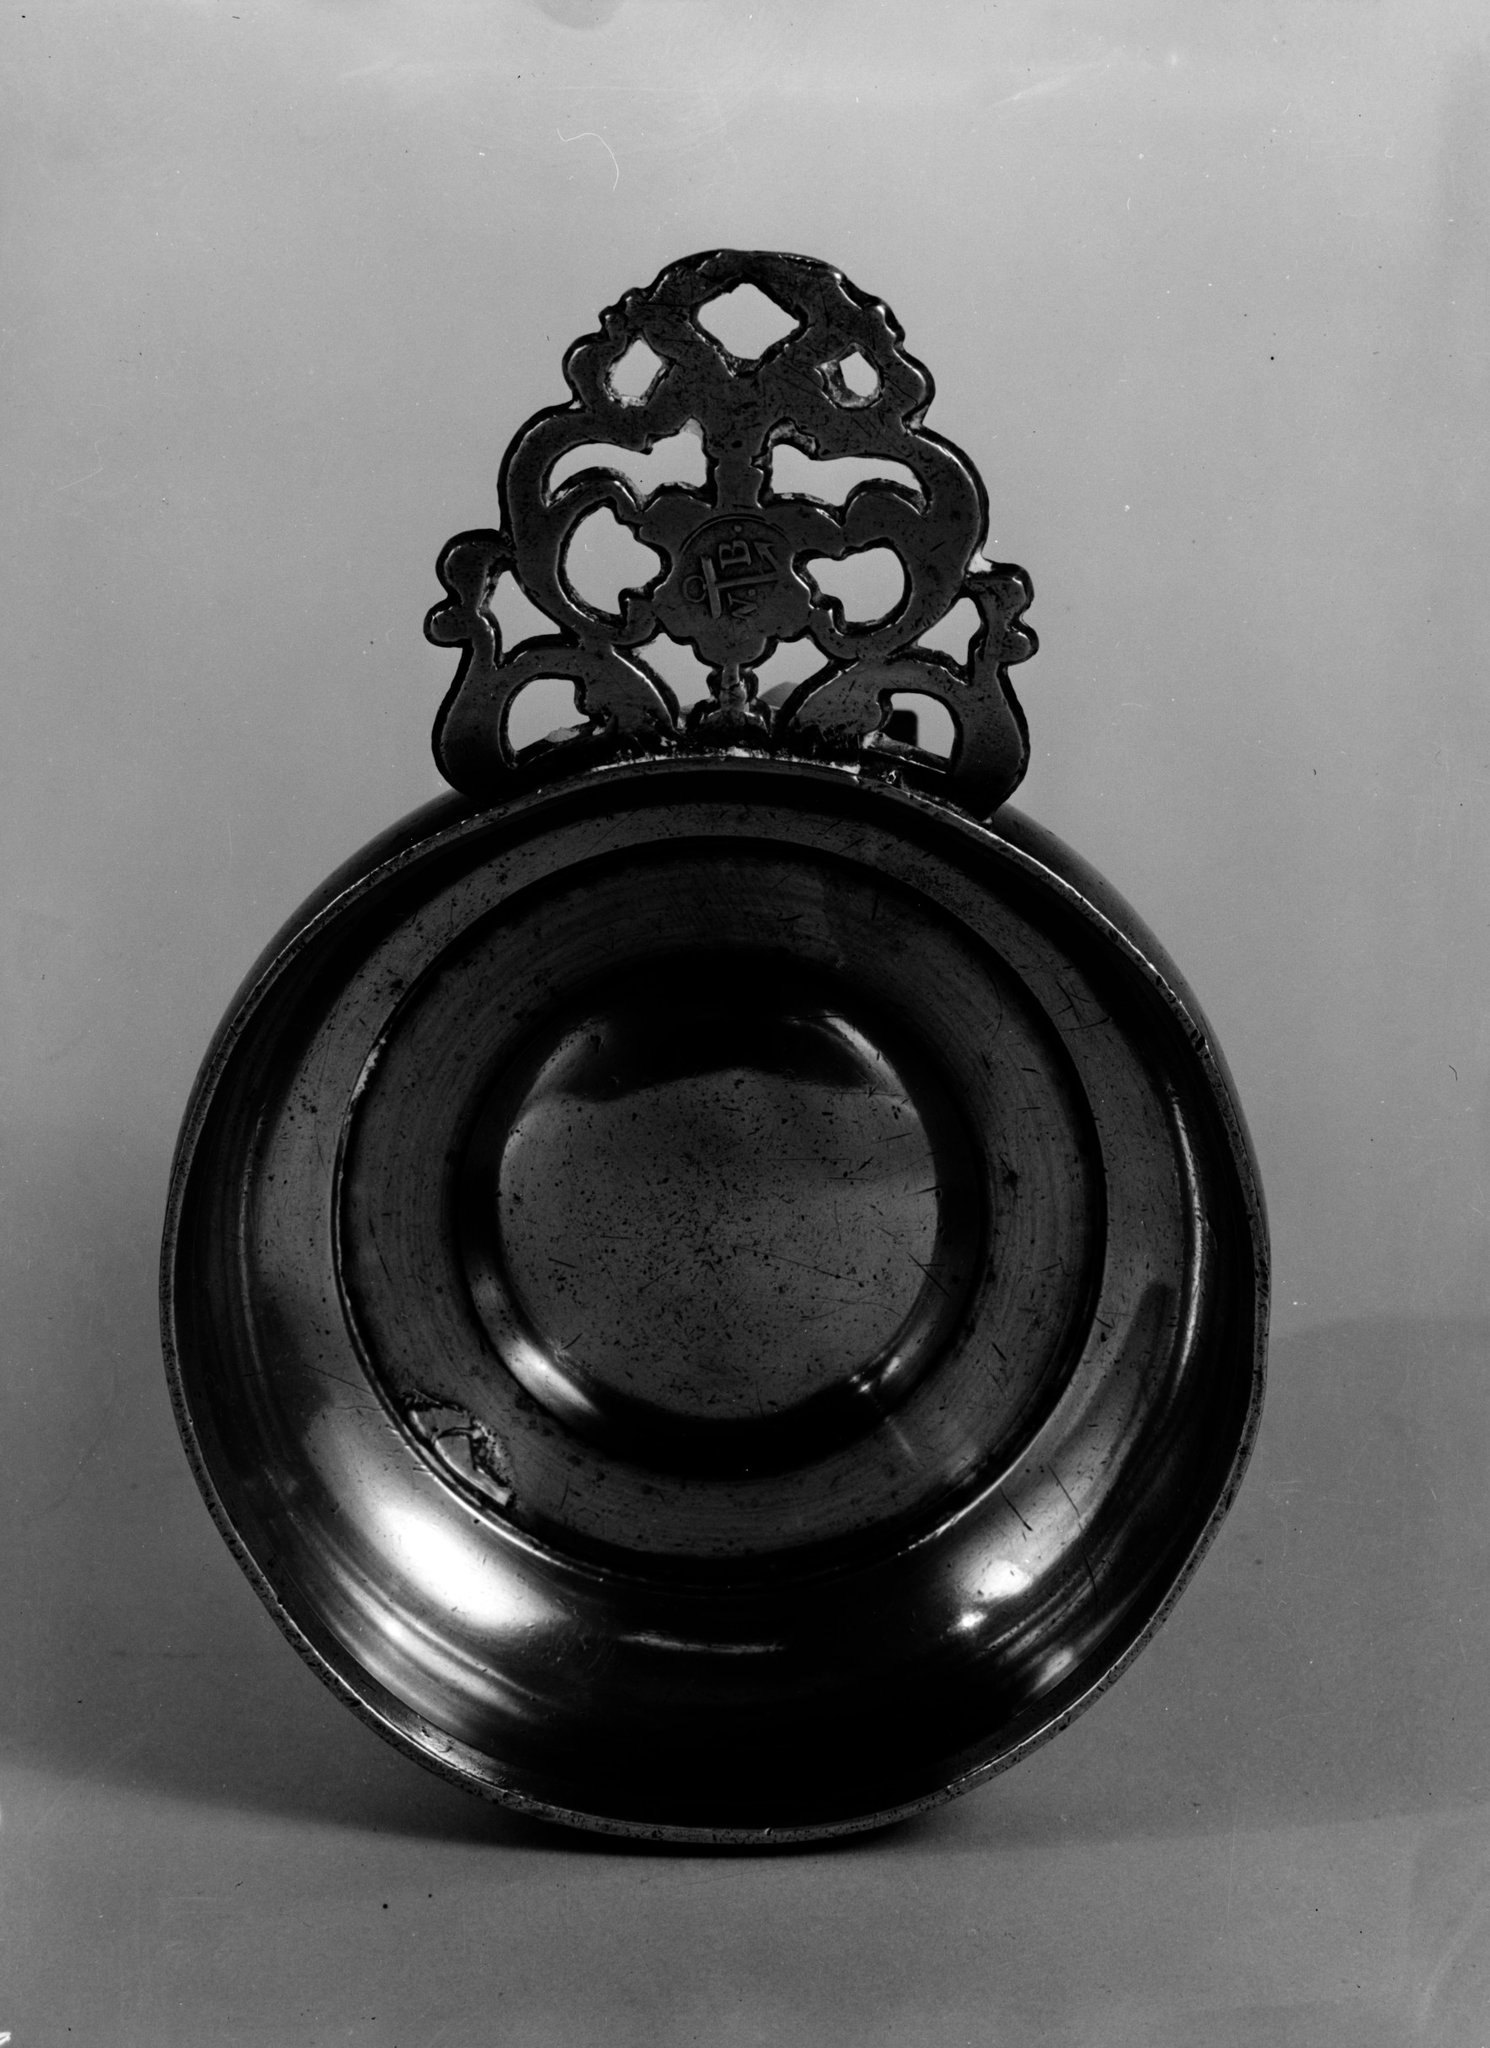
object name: porringer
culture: american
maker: william billings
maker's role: maker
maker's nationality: american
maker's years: 1765-1813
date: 1791-1806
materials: pewter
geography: united states